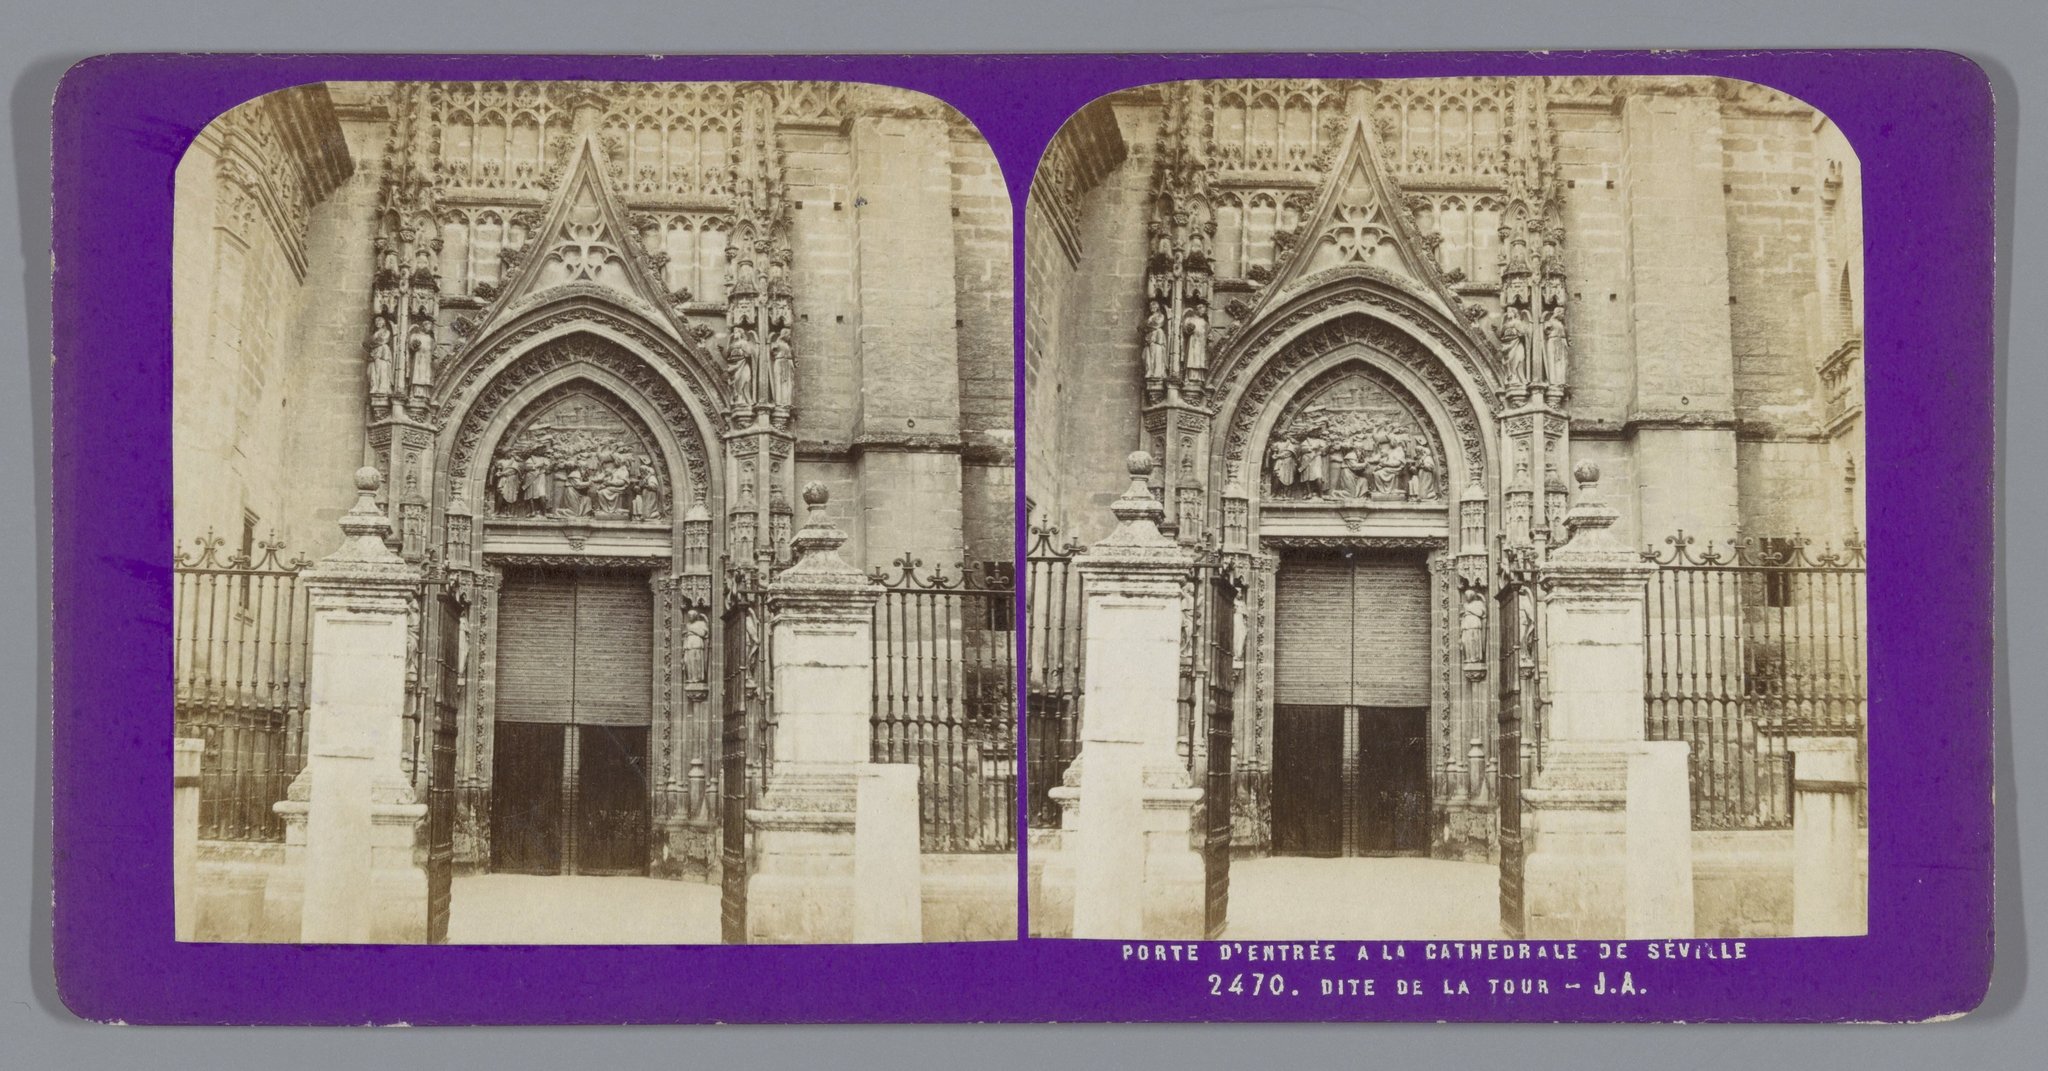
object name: stereograph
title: Portaal van de Kathedraal van Sevilla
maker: jean andrieu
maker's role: fotograaf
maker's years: 1816-1872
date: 1862-1876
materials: cardboard, photographic support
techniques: albumen print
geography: sevilla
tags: parts of church exterior and annexes: portal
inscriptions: number: ‘2470.’